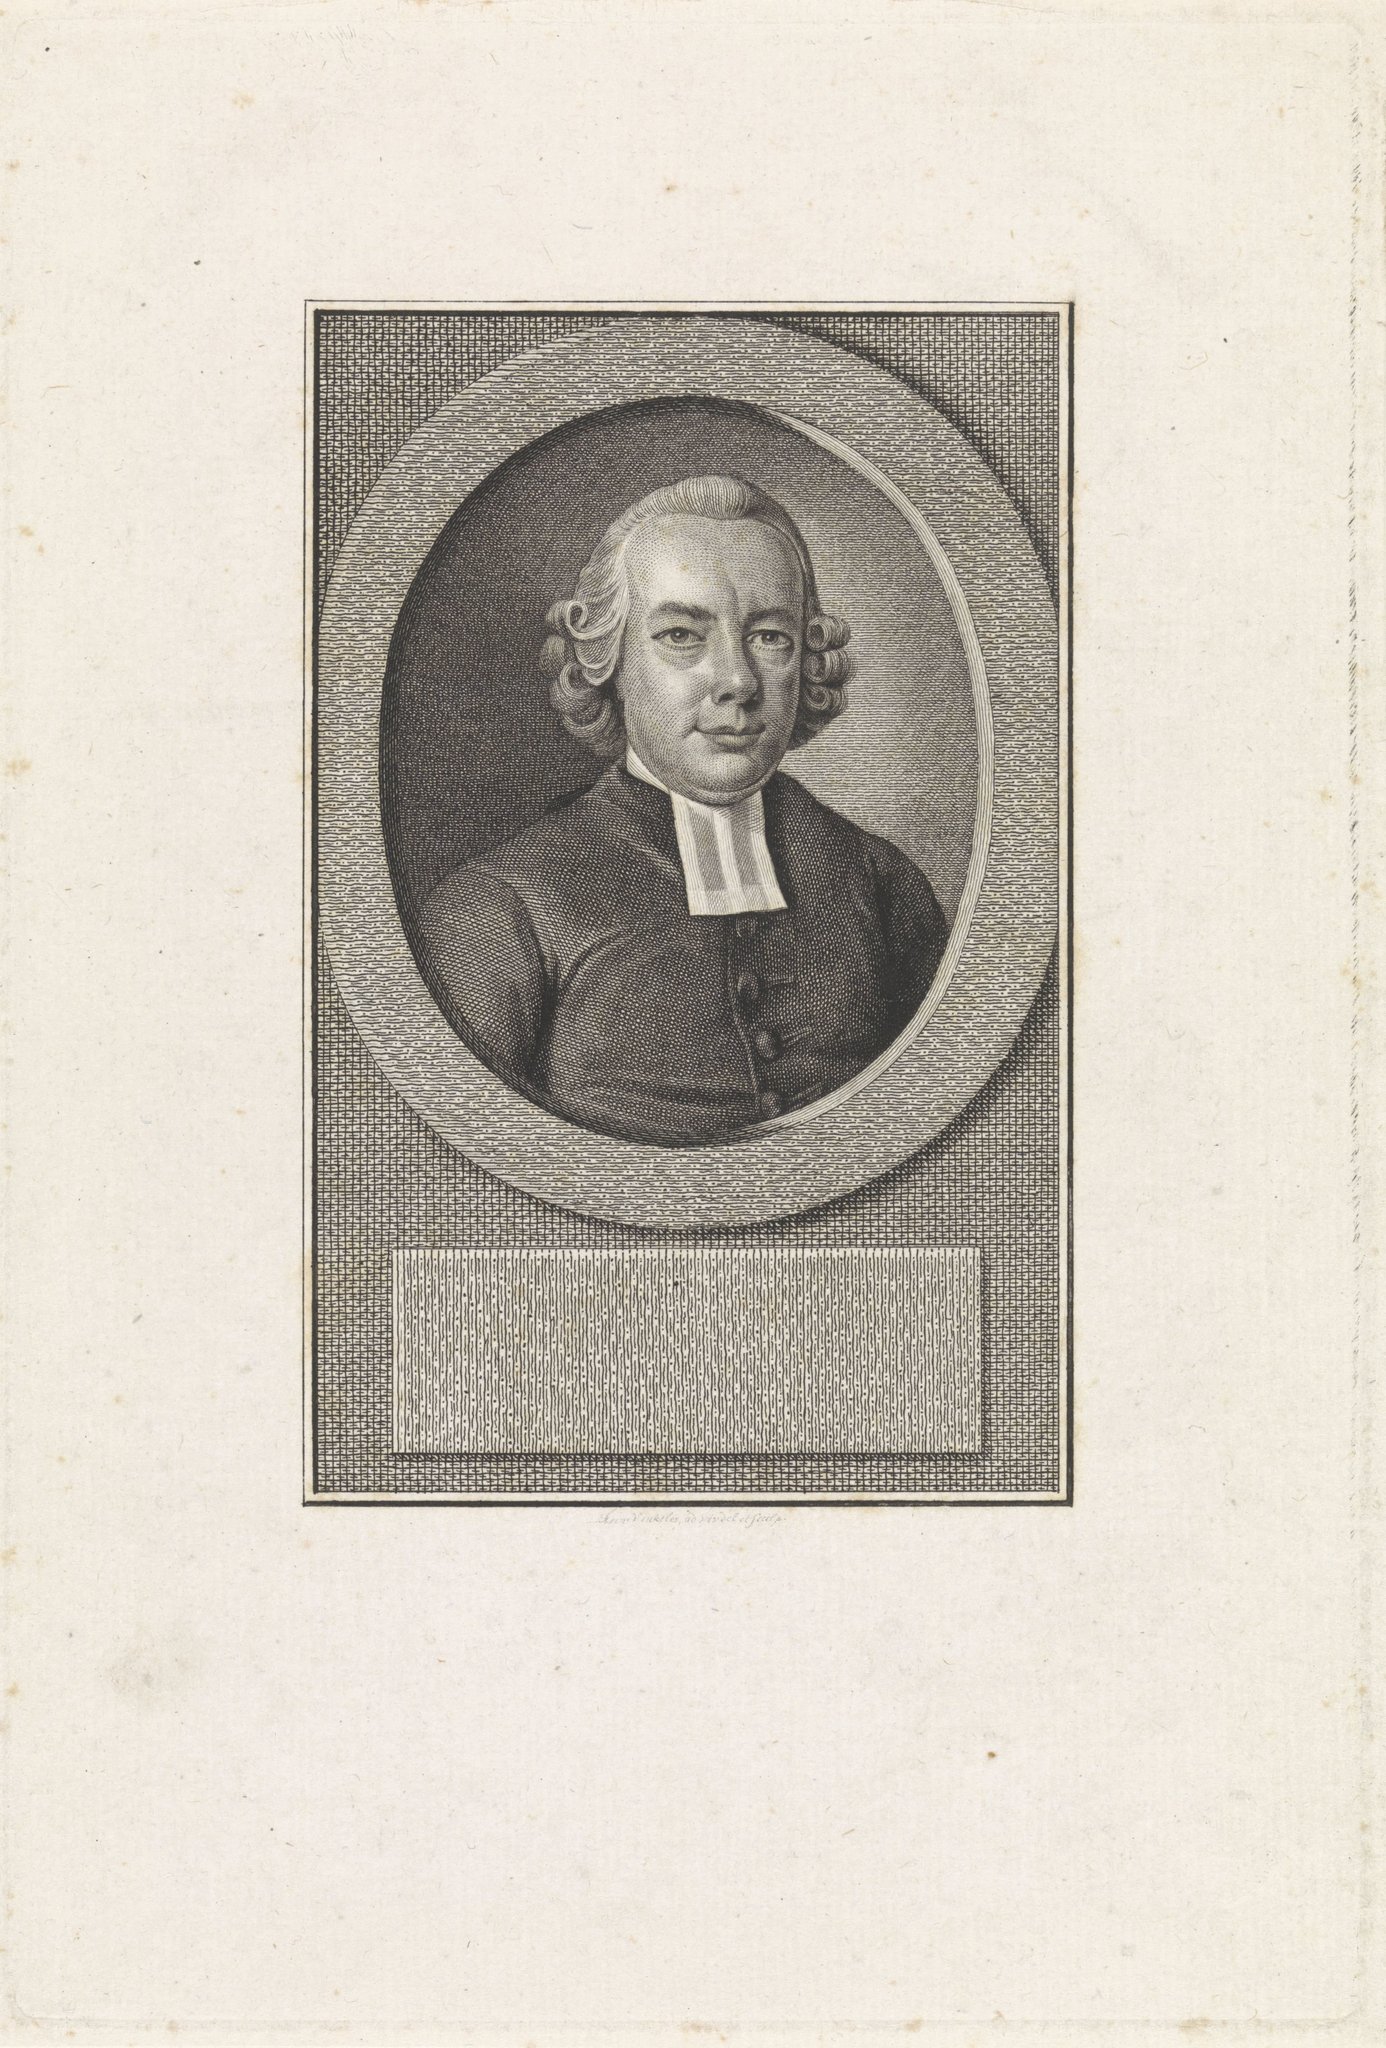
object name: print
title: Portret van Johan Christiaan Baum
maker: reinier vinkeles (i)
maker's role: draughtsman, print maker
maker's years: 1741-1816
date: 1793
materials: paper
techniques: engraving, etching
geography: amsterdam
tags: amsterdam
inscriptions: inscription: Lugt 2228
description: Portret van de Amsterdamse predikant Johan Christiaan Baum op 54-jarige leeftijd.